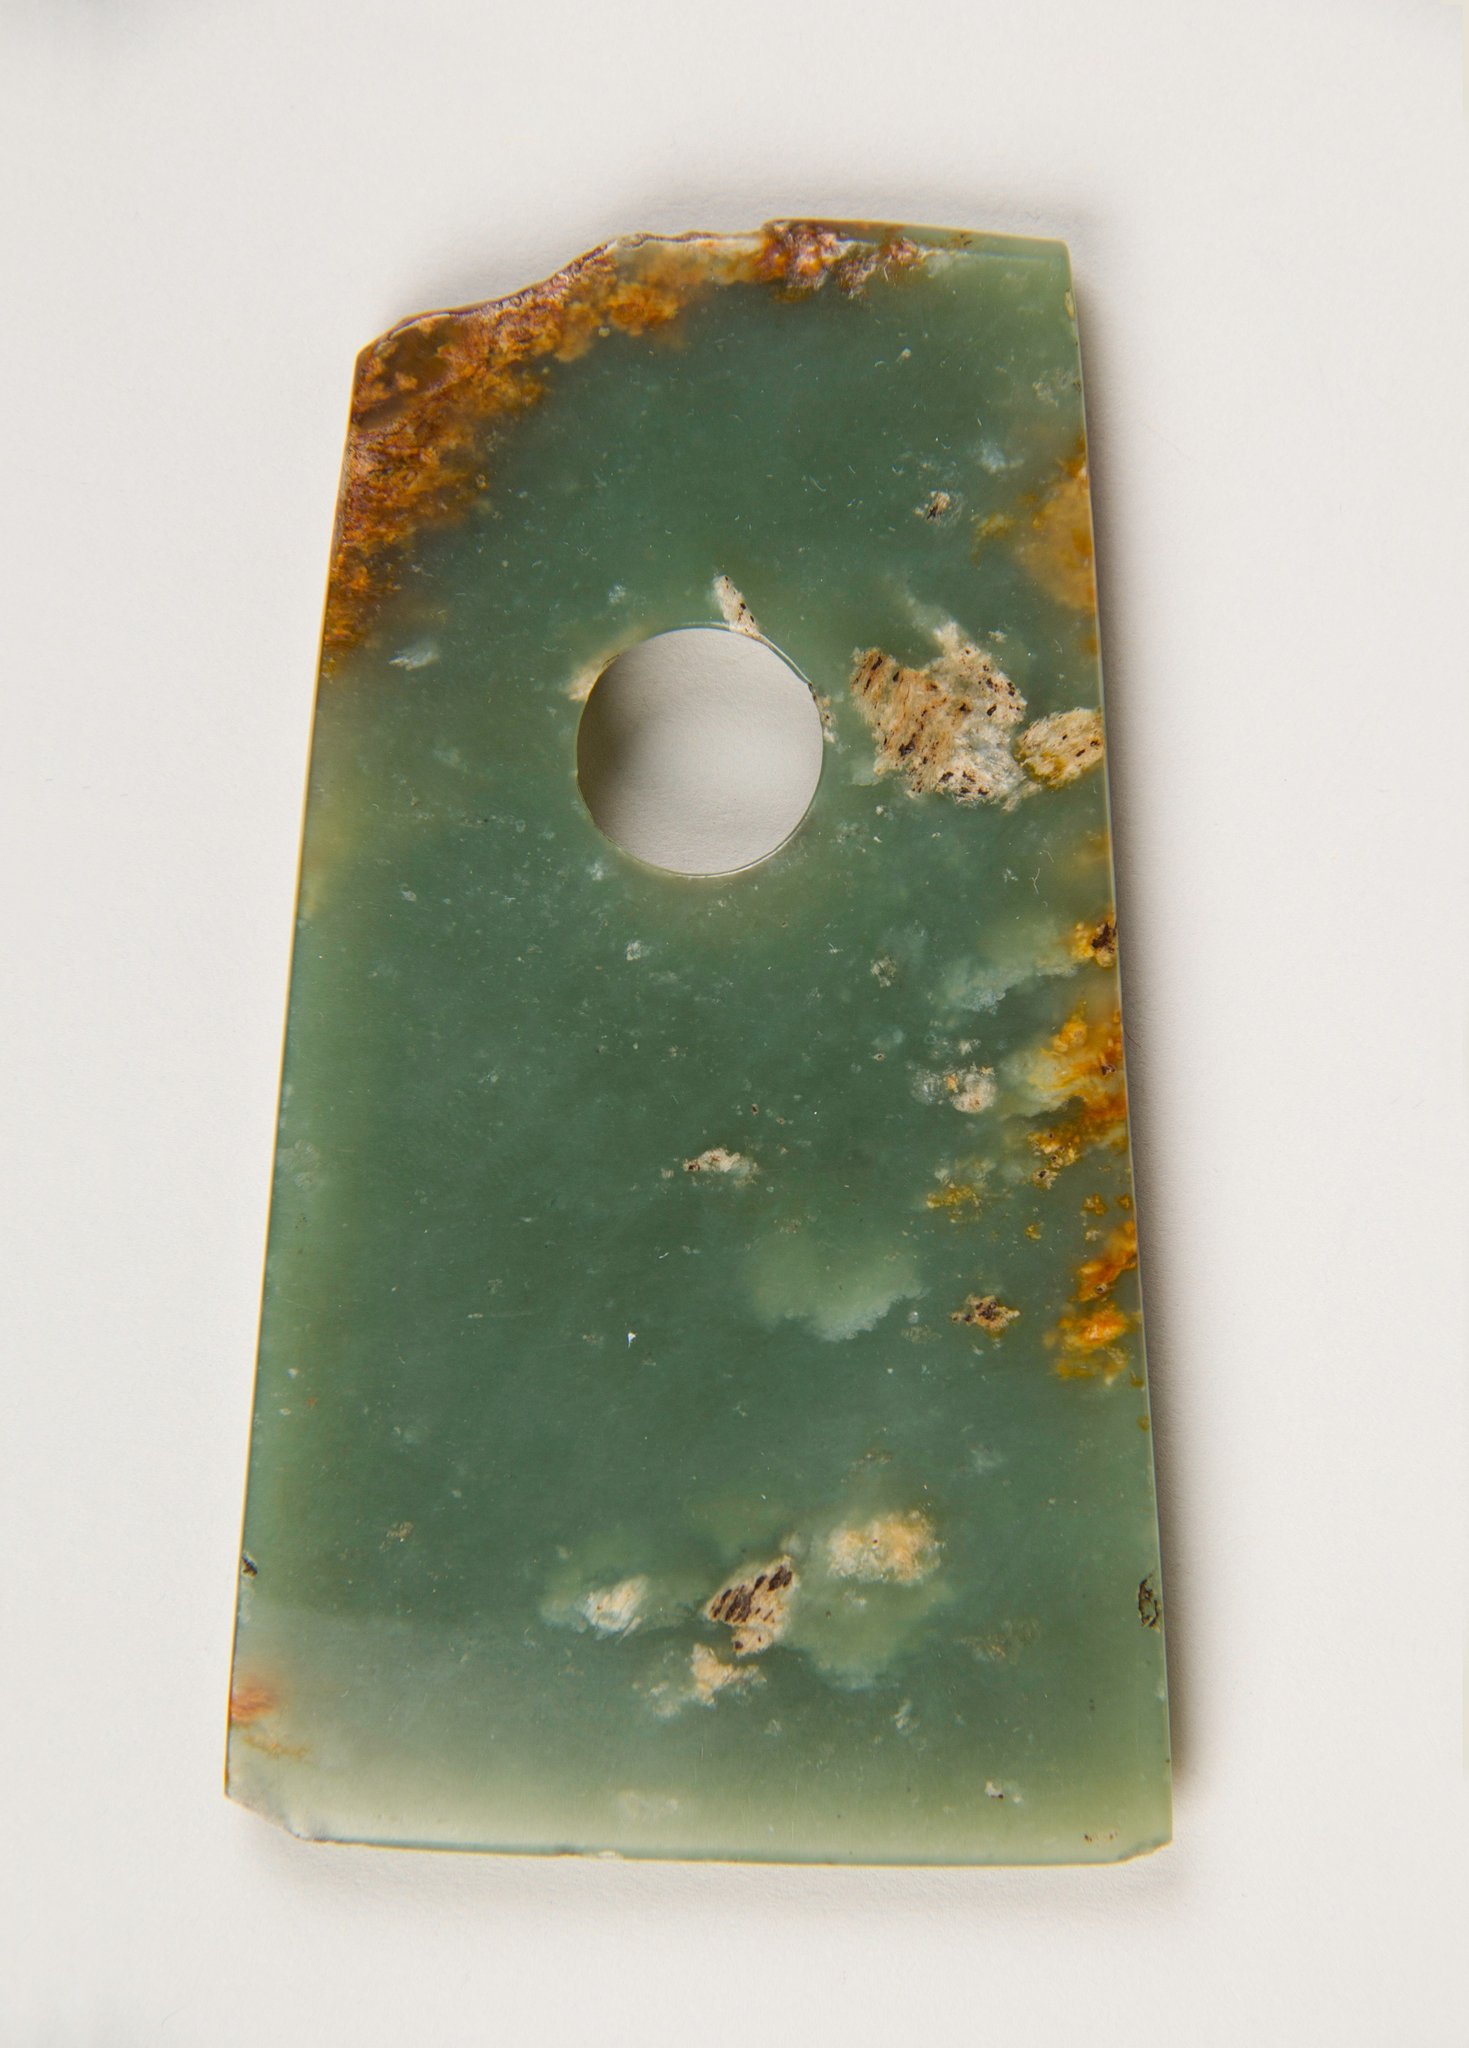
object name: hatchet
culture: chinese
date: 1902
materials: jade